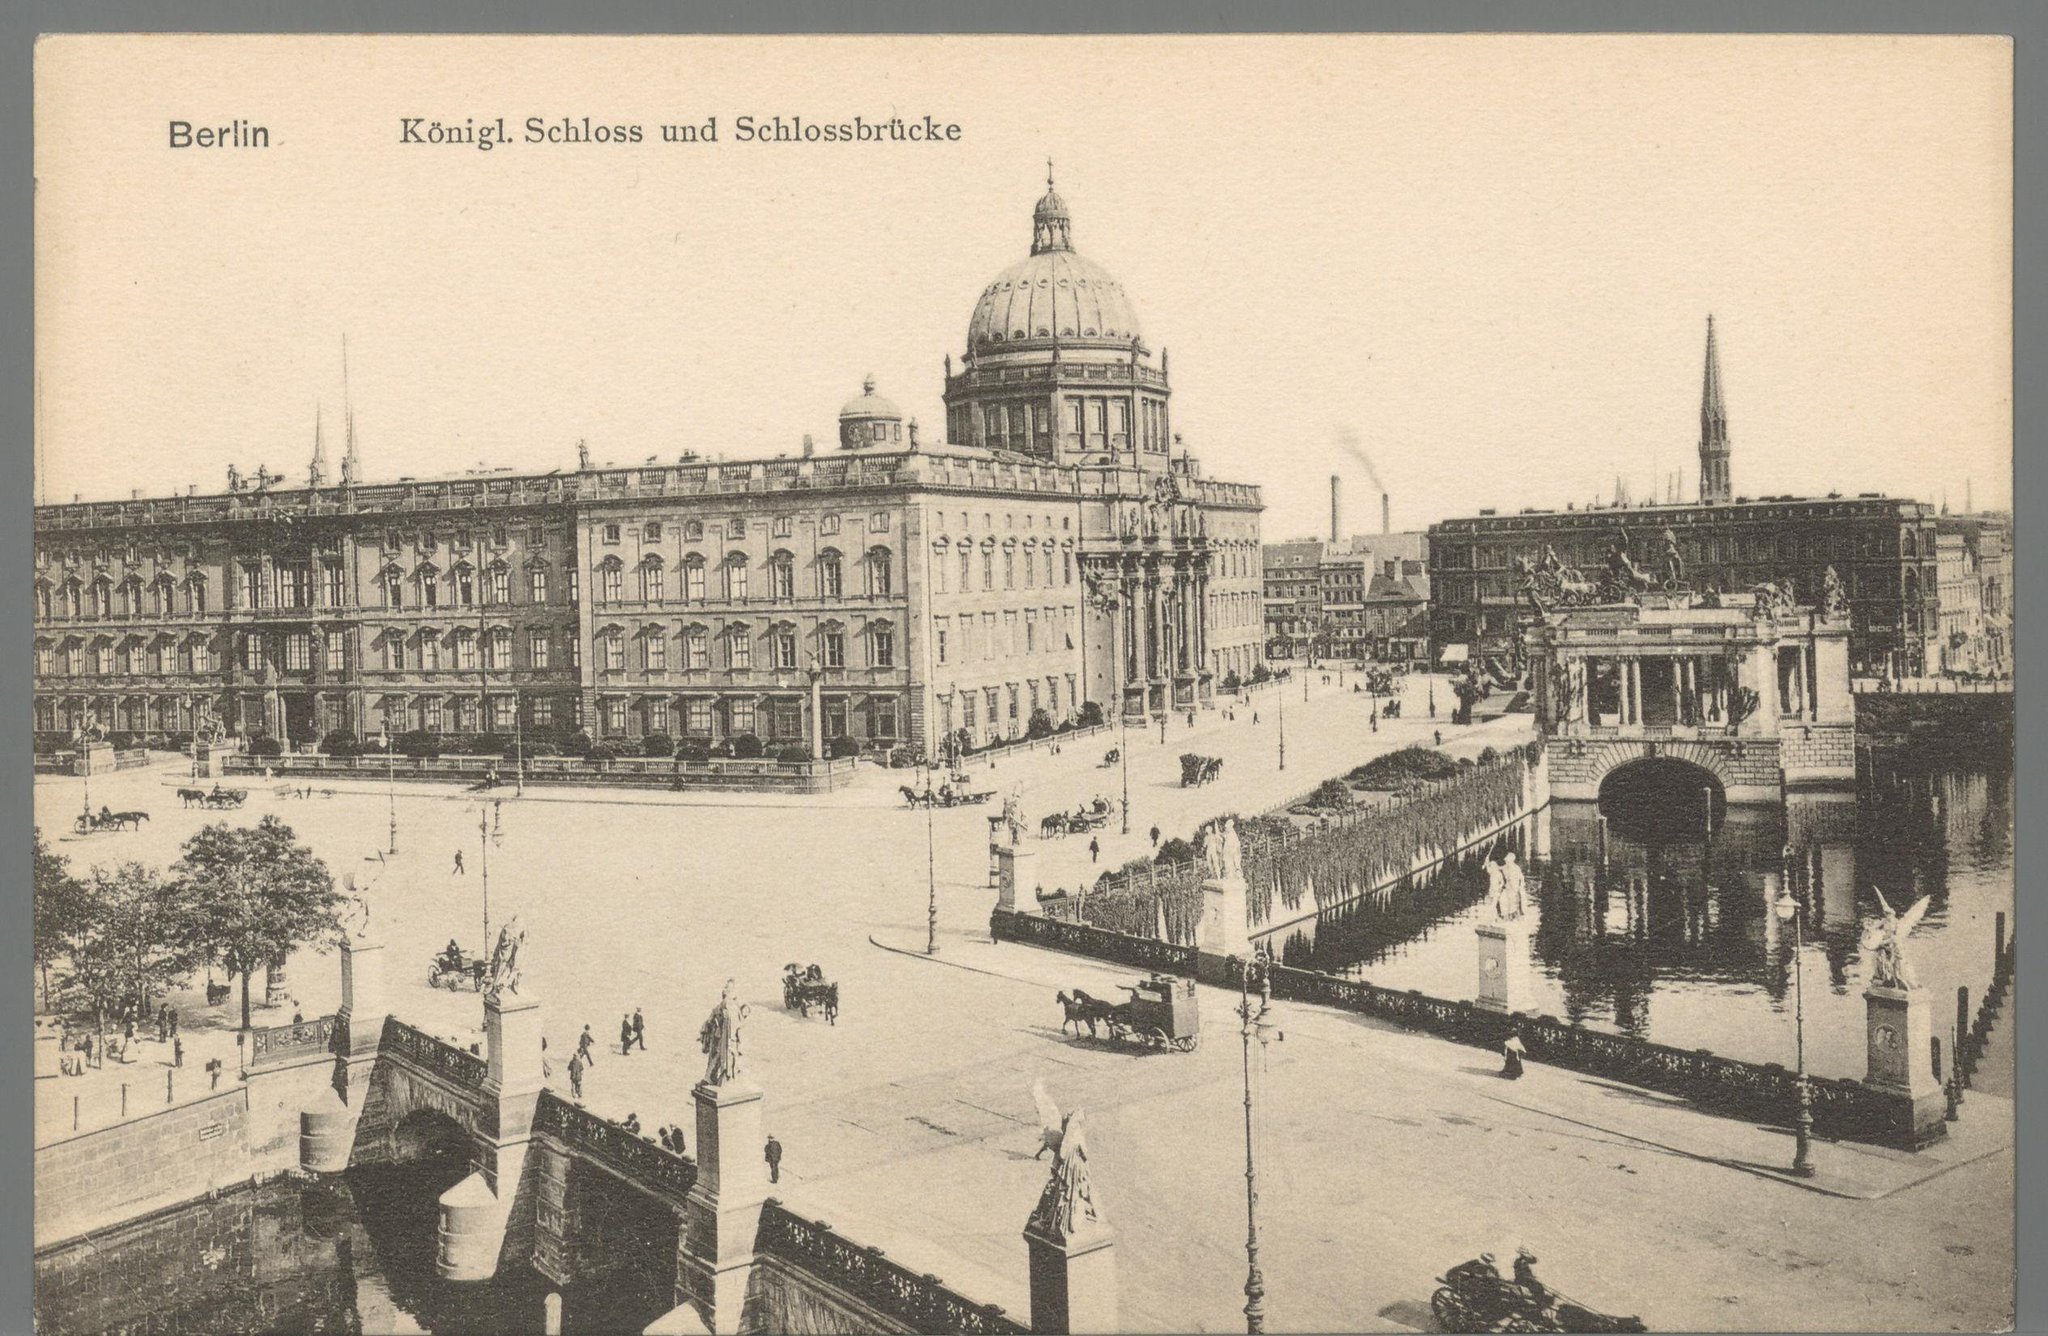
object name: photomechanical print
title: Berlin. Königl. Schloss und Schlossbrücke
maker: Anonymous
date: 1905-1930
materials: cardboard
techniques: photograph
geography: berlin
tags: castle, bridge in city across river, canal, etc.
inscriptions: stamp: ‘5’